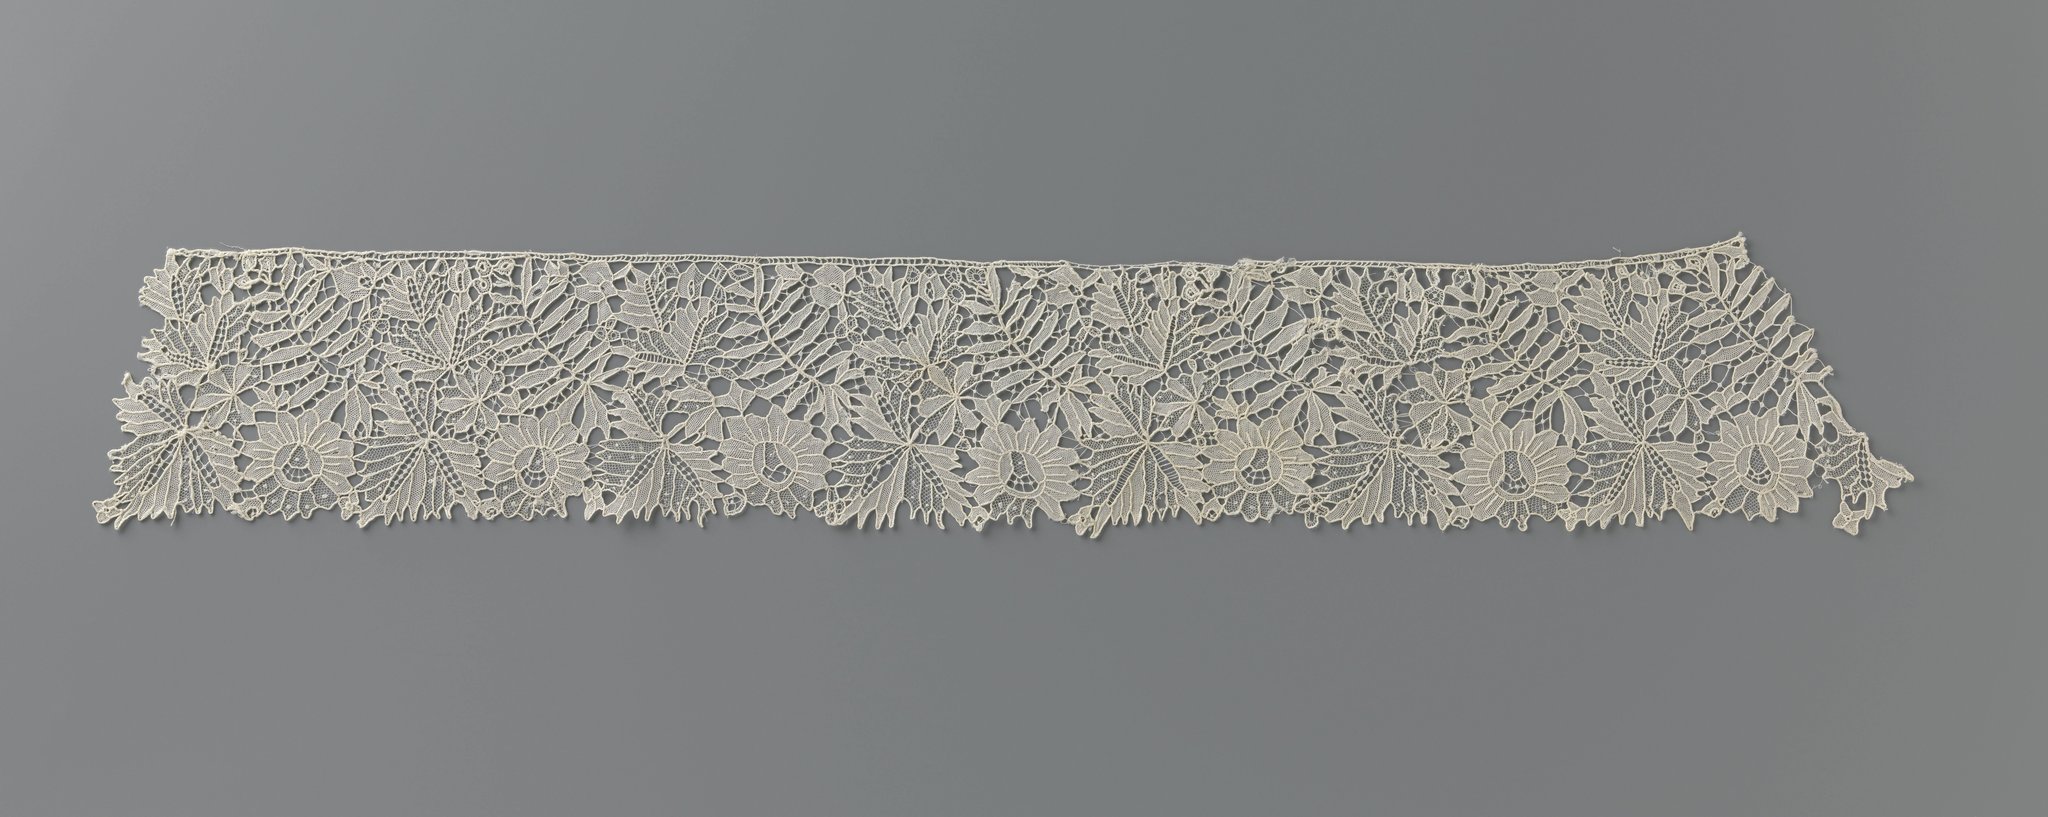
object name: strip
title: Strook naaldkant met ingesneden blad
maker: Anonymous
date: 1900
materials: linen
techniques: needle lace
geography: karlsbad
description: Lopend patroon van ingesneden bladeren boven een roos en een drieblad, die samen de scherp getande buitenlijn vormen. Kruisvormige spijlen met knoopje (grond van lange X-vormige spijlen met een spin). Het remplis bestaat uit knoopsgatensteken en een fond gazé. Duitse kant: 'Carlsbader Points'.